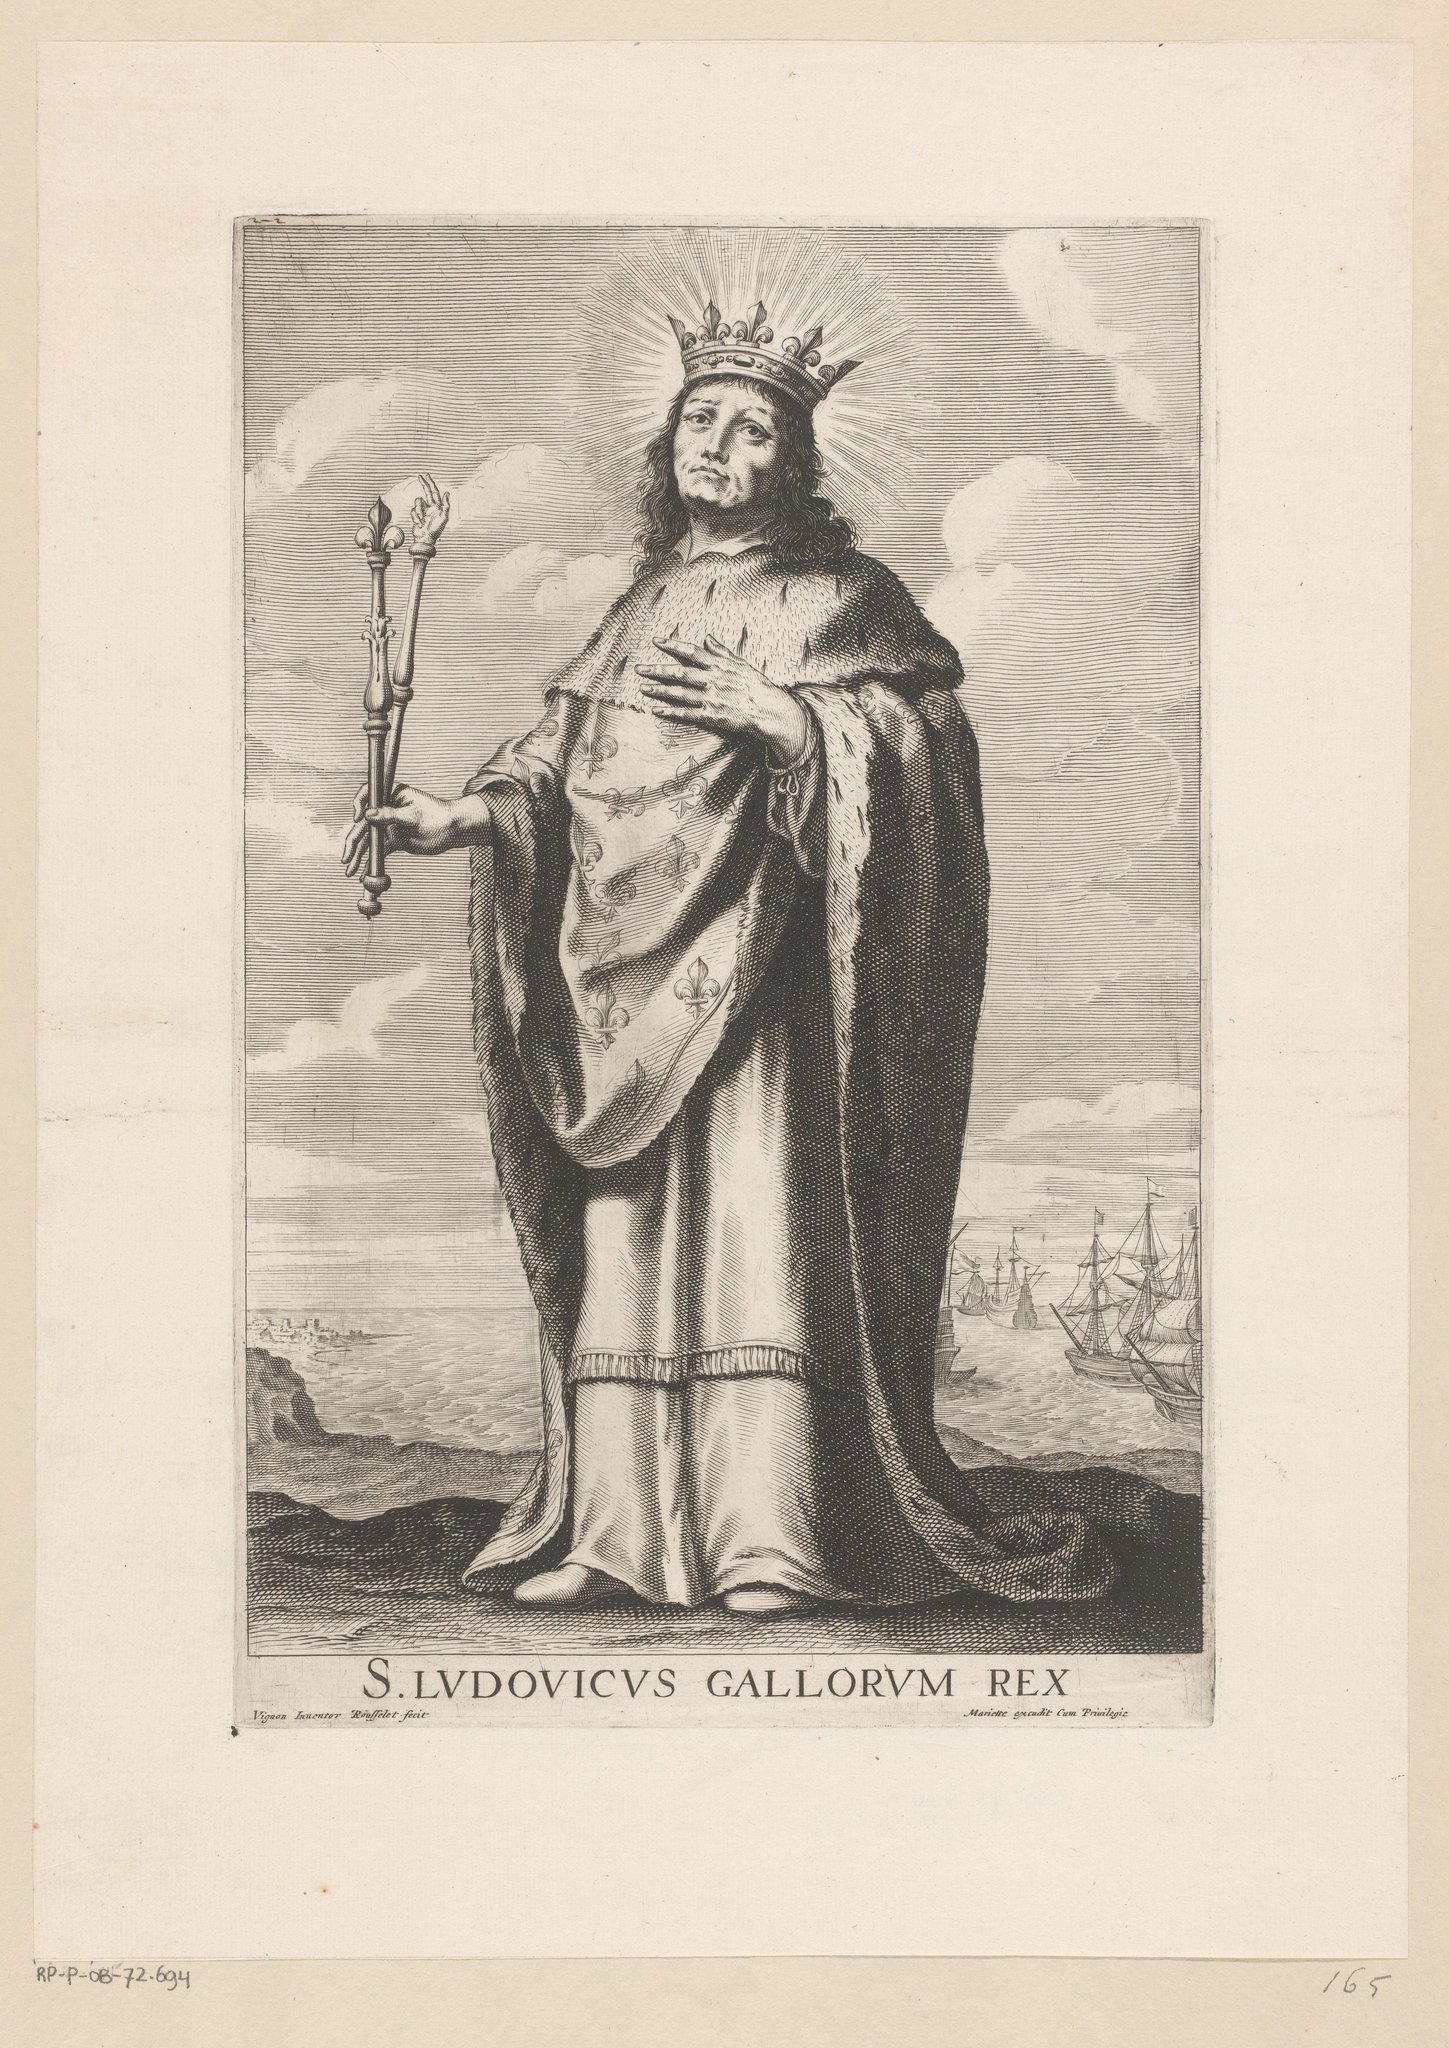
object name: print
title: Portret van Lodewijk IX de Heilige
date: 1620-1686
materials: paper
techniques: engraving, etching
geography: france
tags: historical persons, louis ix, king of france; possible attributes: crown of thorns, fleur-de-lis on his coat, three nails, sceptre with fleur-de-lis, model of church, hand of justice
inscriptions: collector's mark: Lugt 240